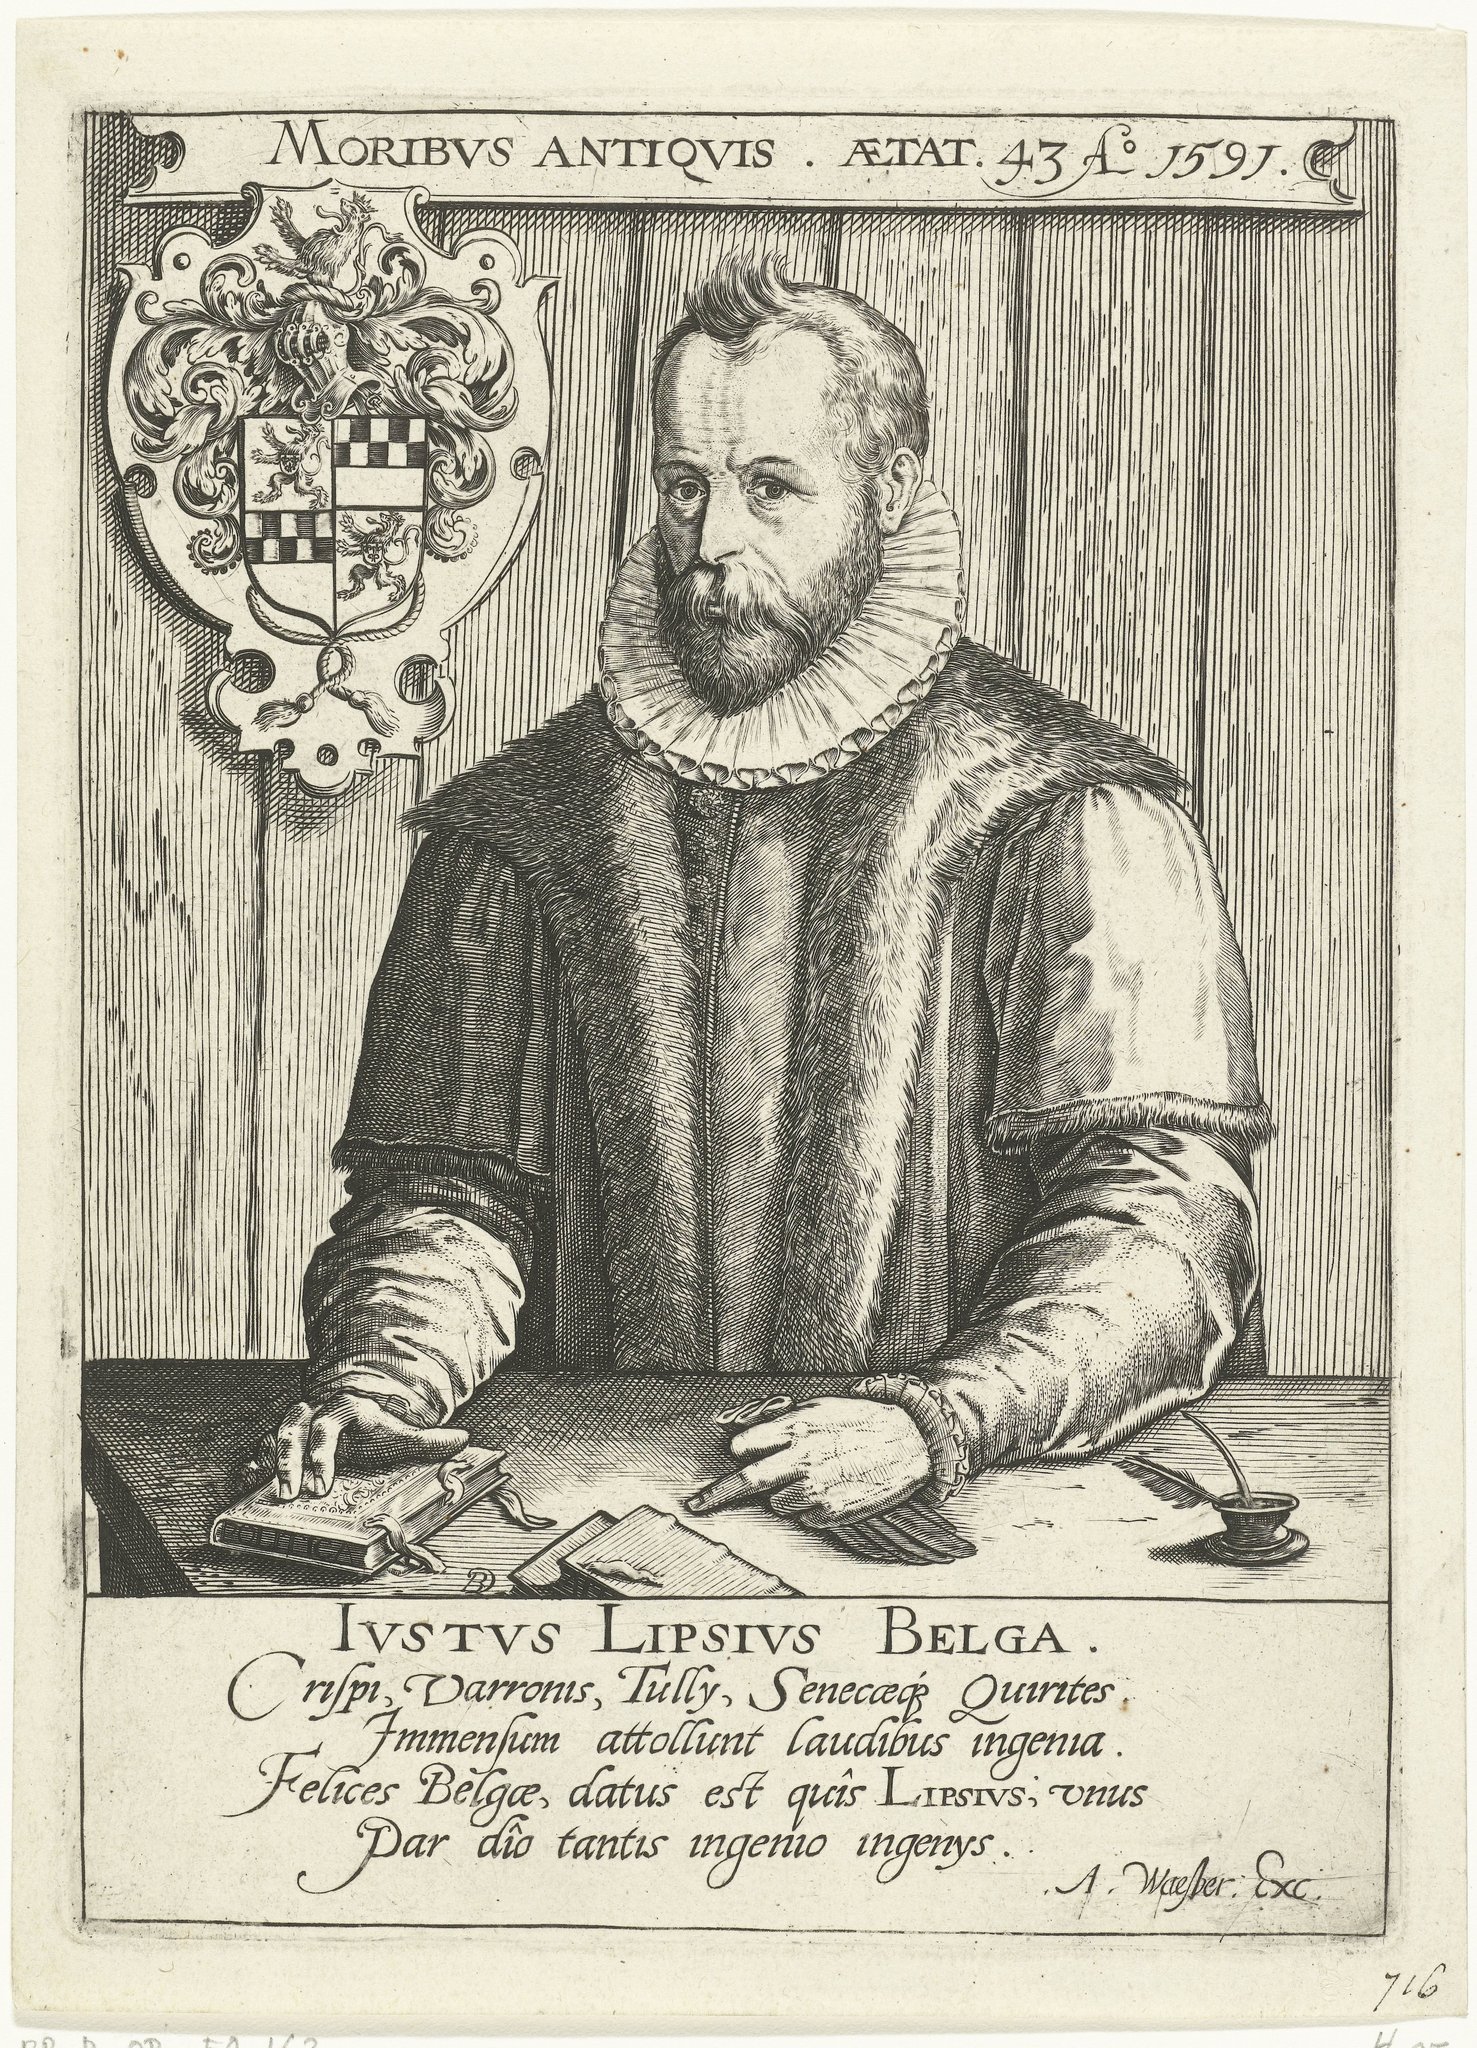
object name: print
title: Portret van Justus Lipsius op 43-jarige leeftijd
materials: paper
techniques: engraving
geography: leiden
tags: louvain, justus lipsius, historical persons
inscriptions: collector's mark: Lugt 240, number: ‘716’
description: Portret van de humanist en geleerde Justus Lipsius aan zijn schrijftafel met een boek in zijn hand. Links boven zijn wapen. Onder het portret zijn naam en een Latijns vers.